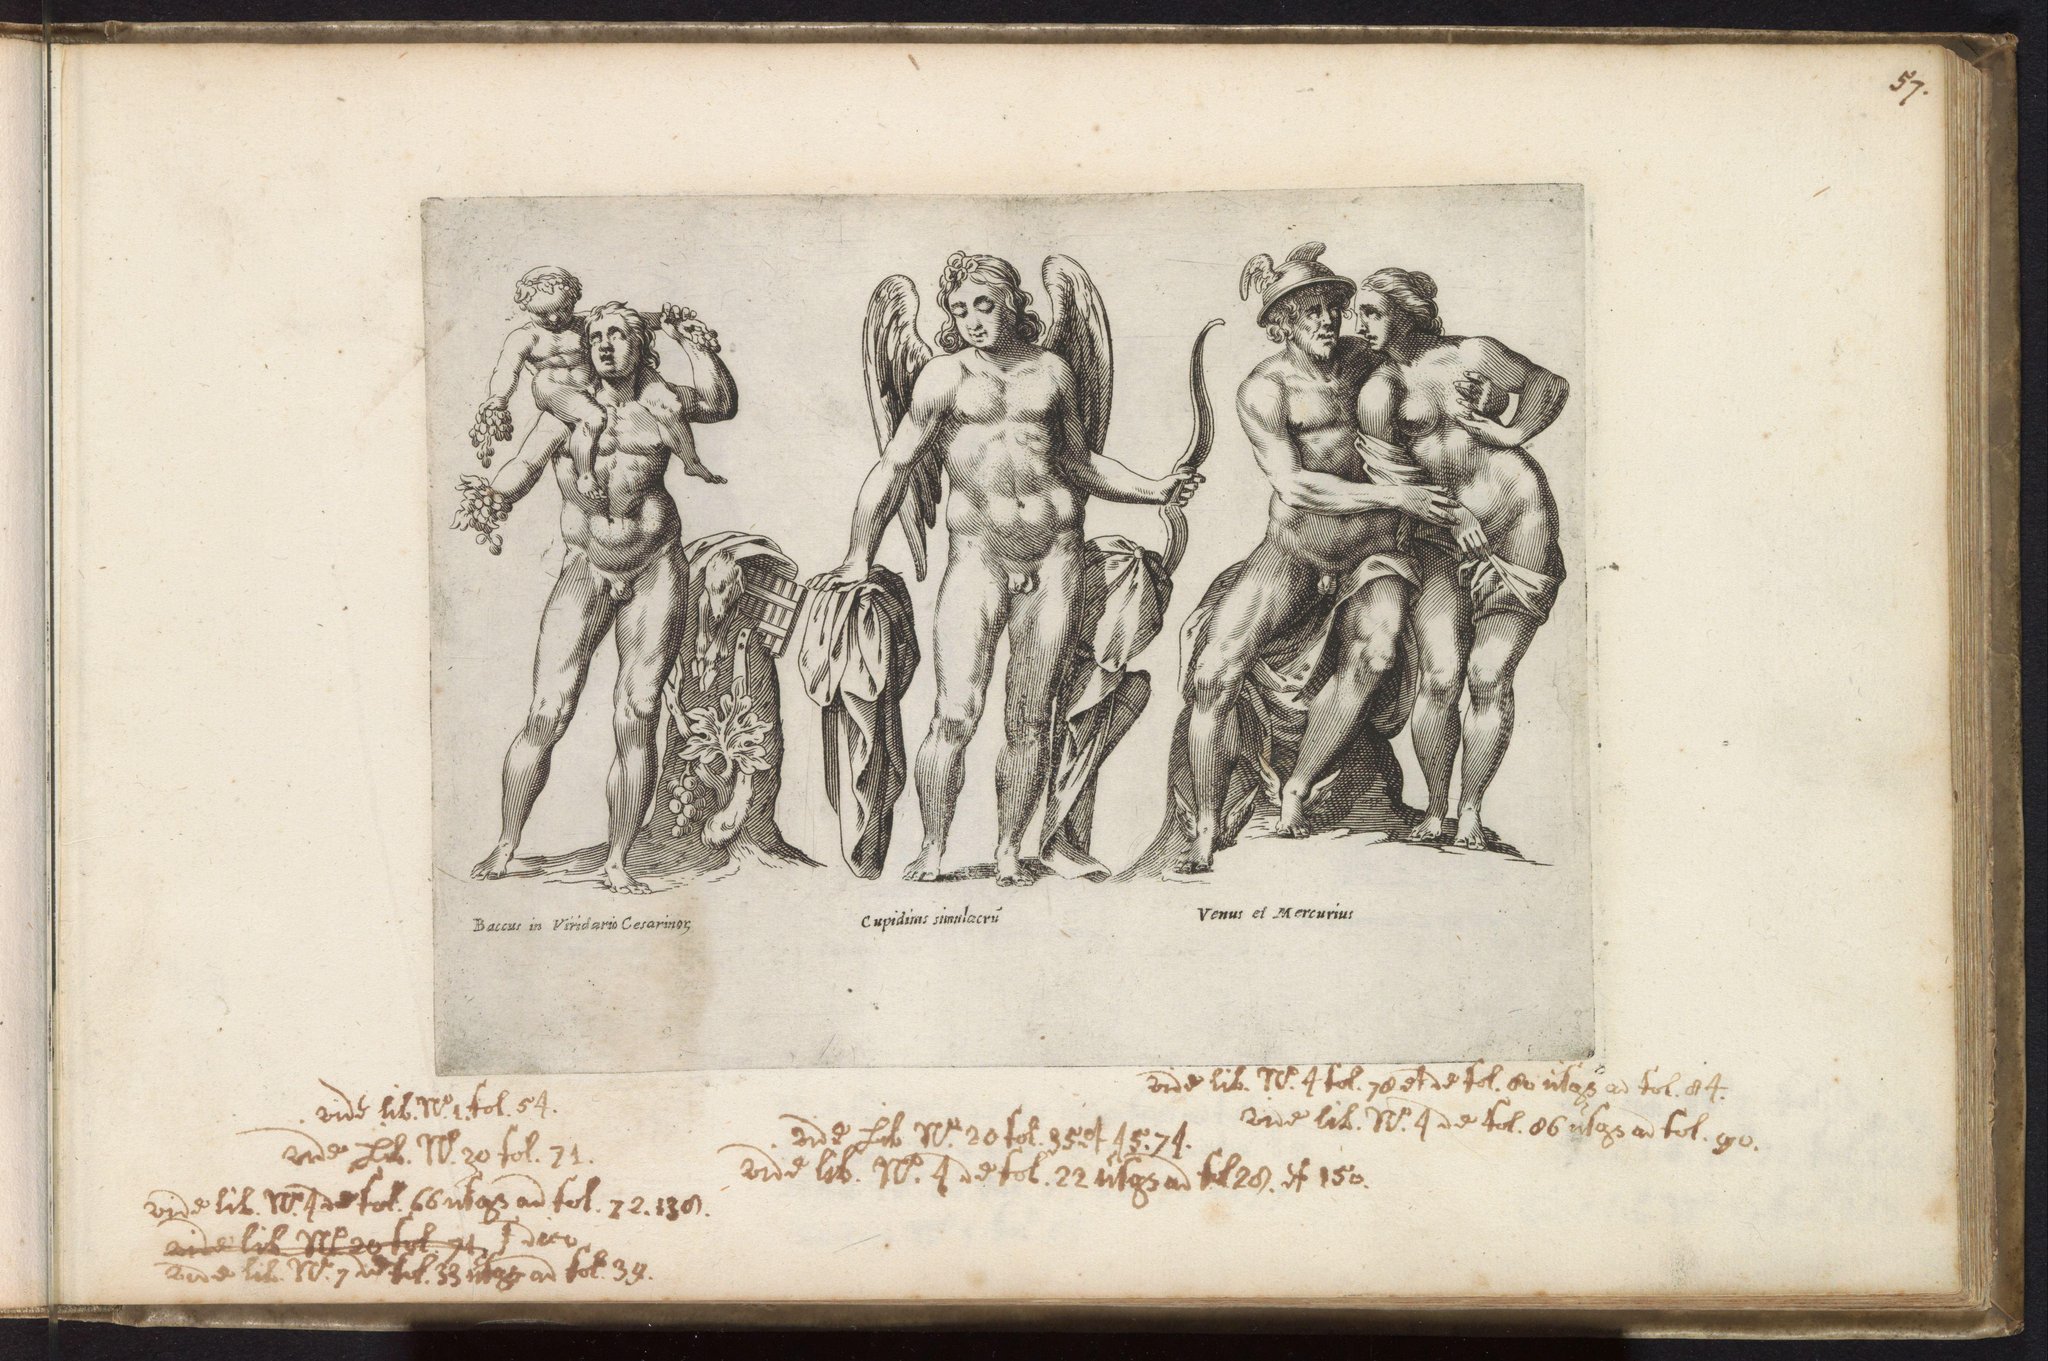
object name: album leaf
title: Sculpturen uit de oudheid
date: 1538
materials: paper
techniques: engraving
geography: rome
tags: (story of) bacchus (dionysus), liber, piece of sculpture, reproduction of a piece of sculpture, (story of) cupid, amor (eros), mercury and venus as lovers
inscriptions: number: ‘57’, inscription: ‘Ende lib. No. 1 fol. 54./ Ende lib. No. 20 fol. 21...’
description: Deze prent maakt deel uit van een reeks van ten minste 19 prenten van sculpturen uit de oudheid. Het beeld van Bacchus bevindt zich in Palazzo Farnese te Rome.